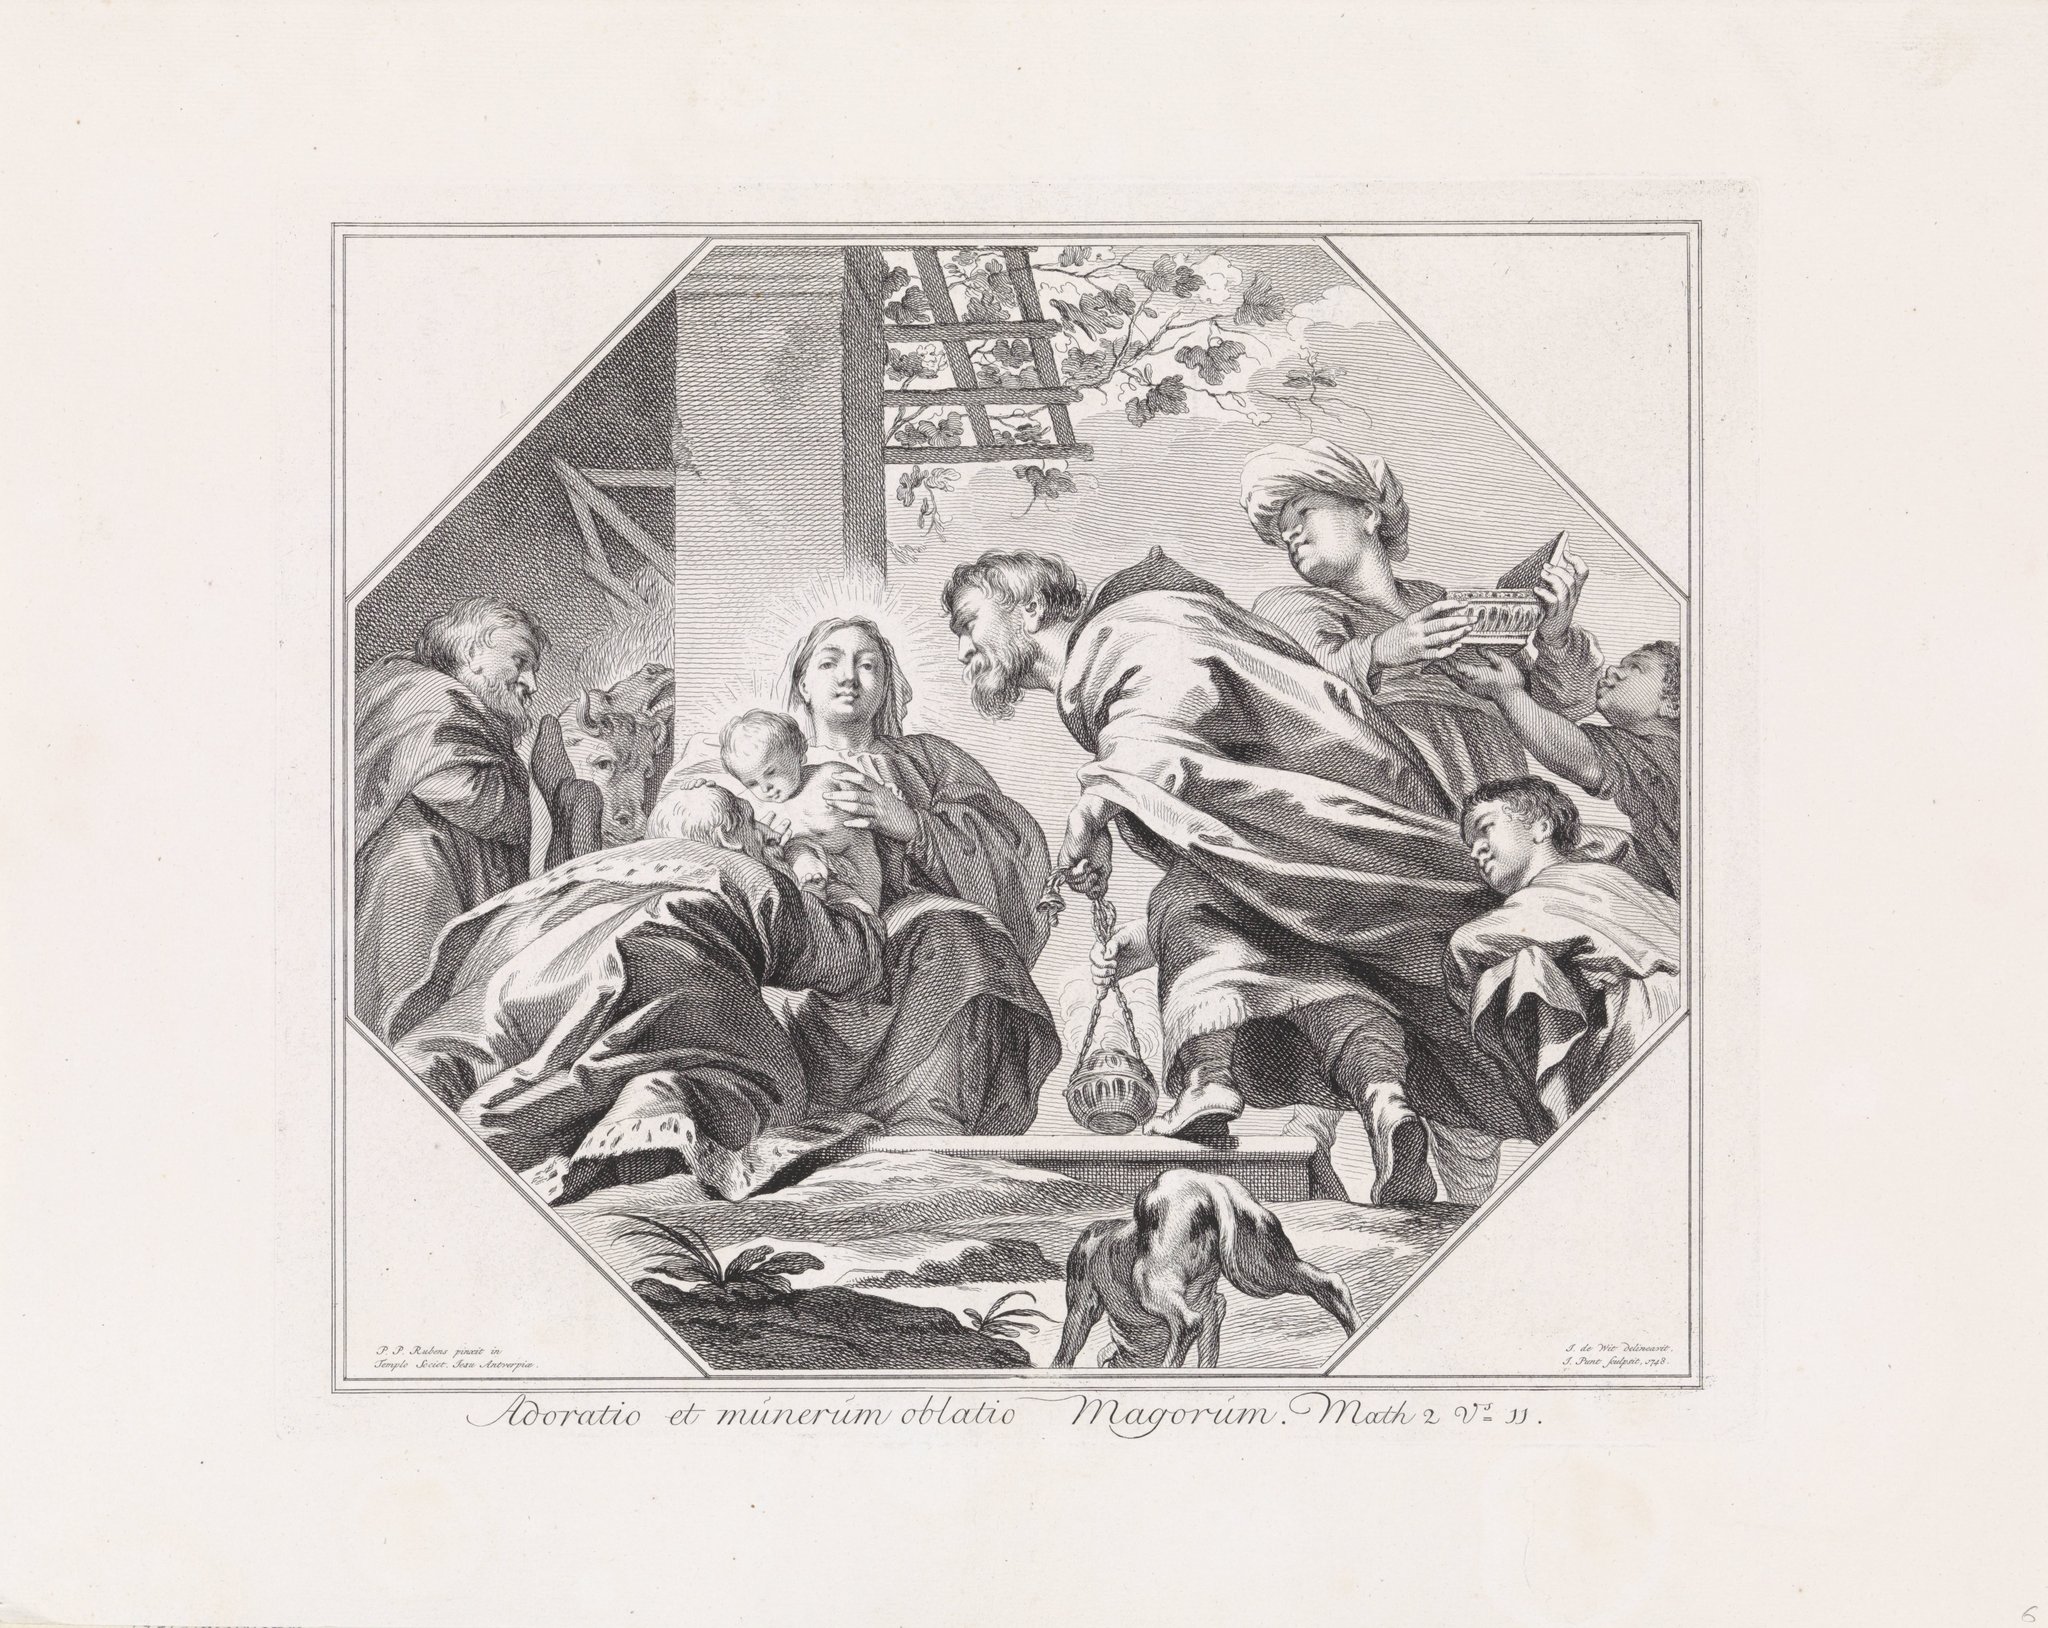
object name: print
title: Aanbidding door de koningen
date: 1748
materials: paper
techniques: engraving, etching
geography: amsterdam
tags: adoration of the kings: the wise men present their gifts to the christ-child (gold, frankincense and myrrh)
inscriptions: date: ‘1748’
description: Aanbidding door de koningen. Onder de octagonale voorstelling een vers in het Latijn uit Mat. 2:11.